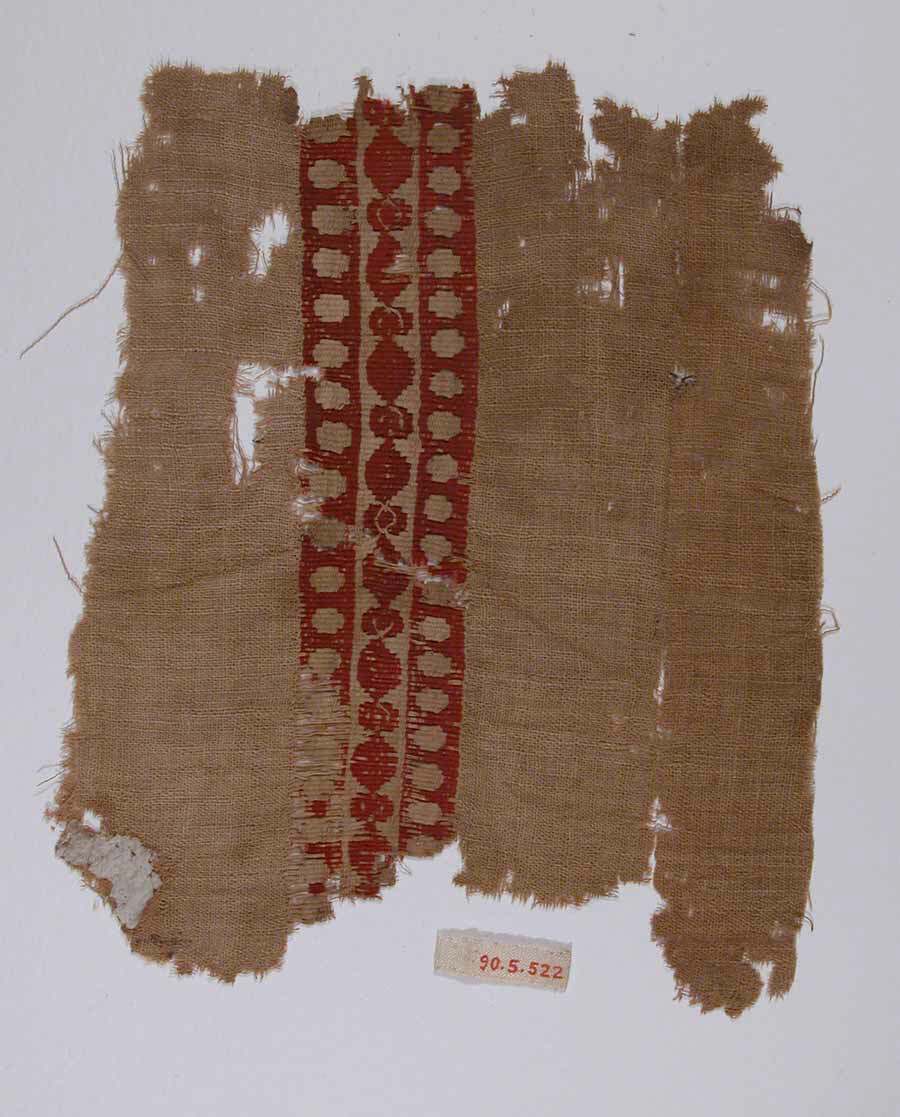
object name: textile fragment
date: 201-400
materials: linen, wool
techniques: weave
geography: egypt